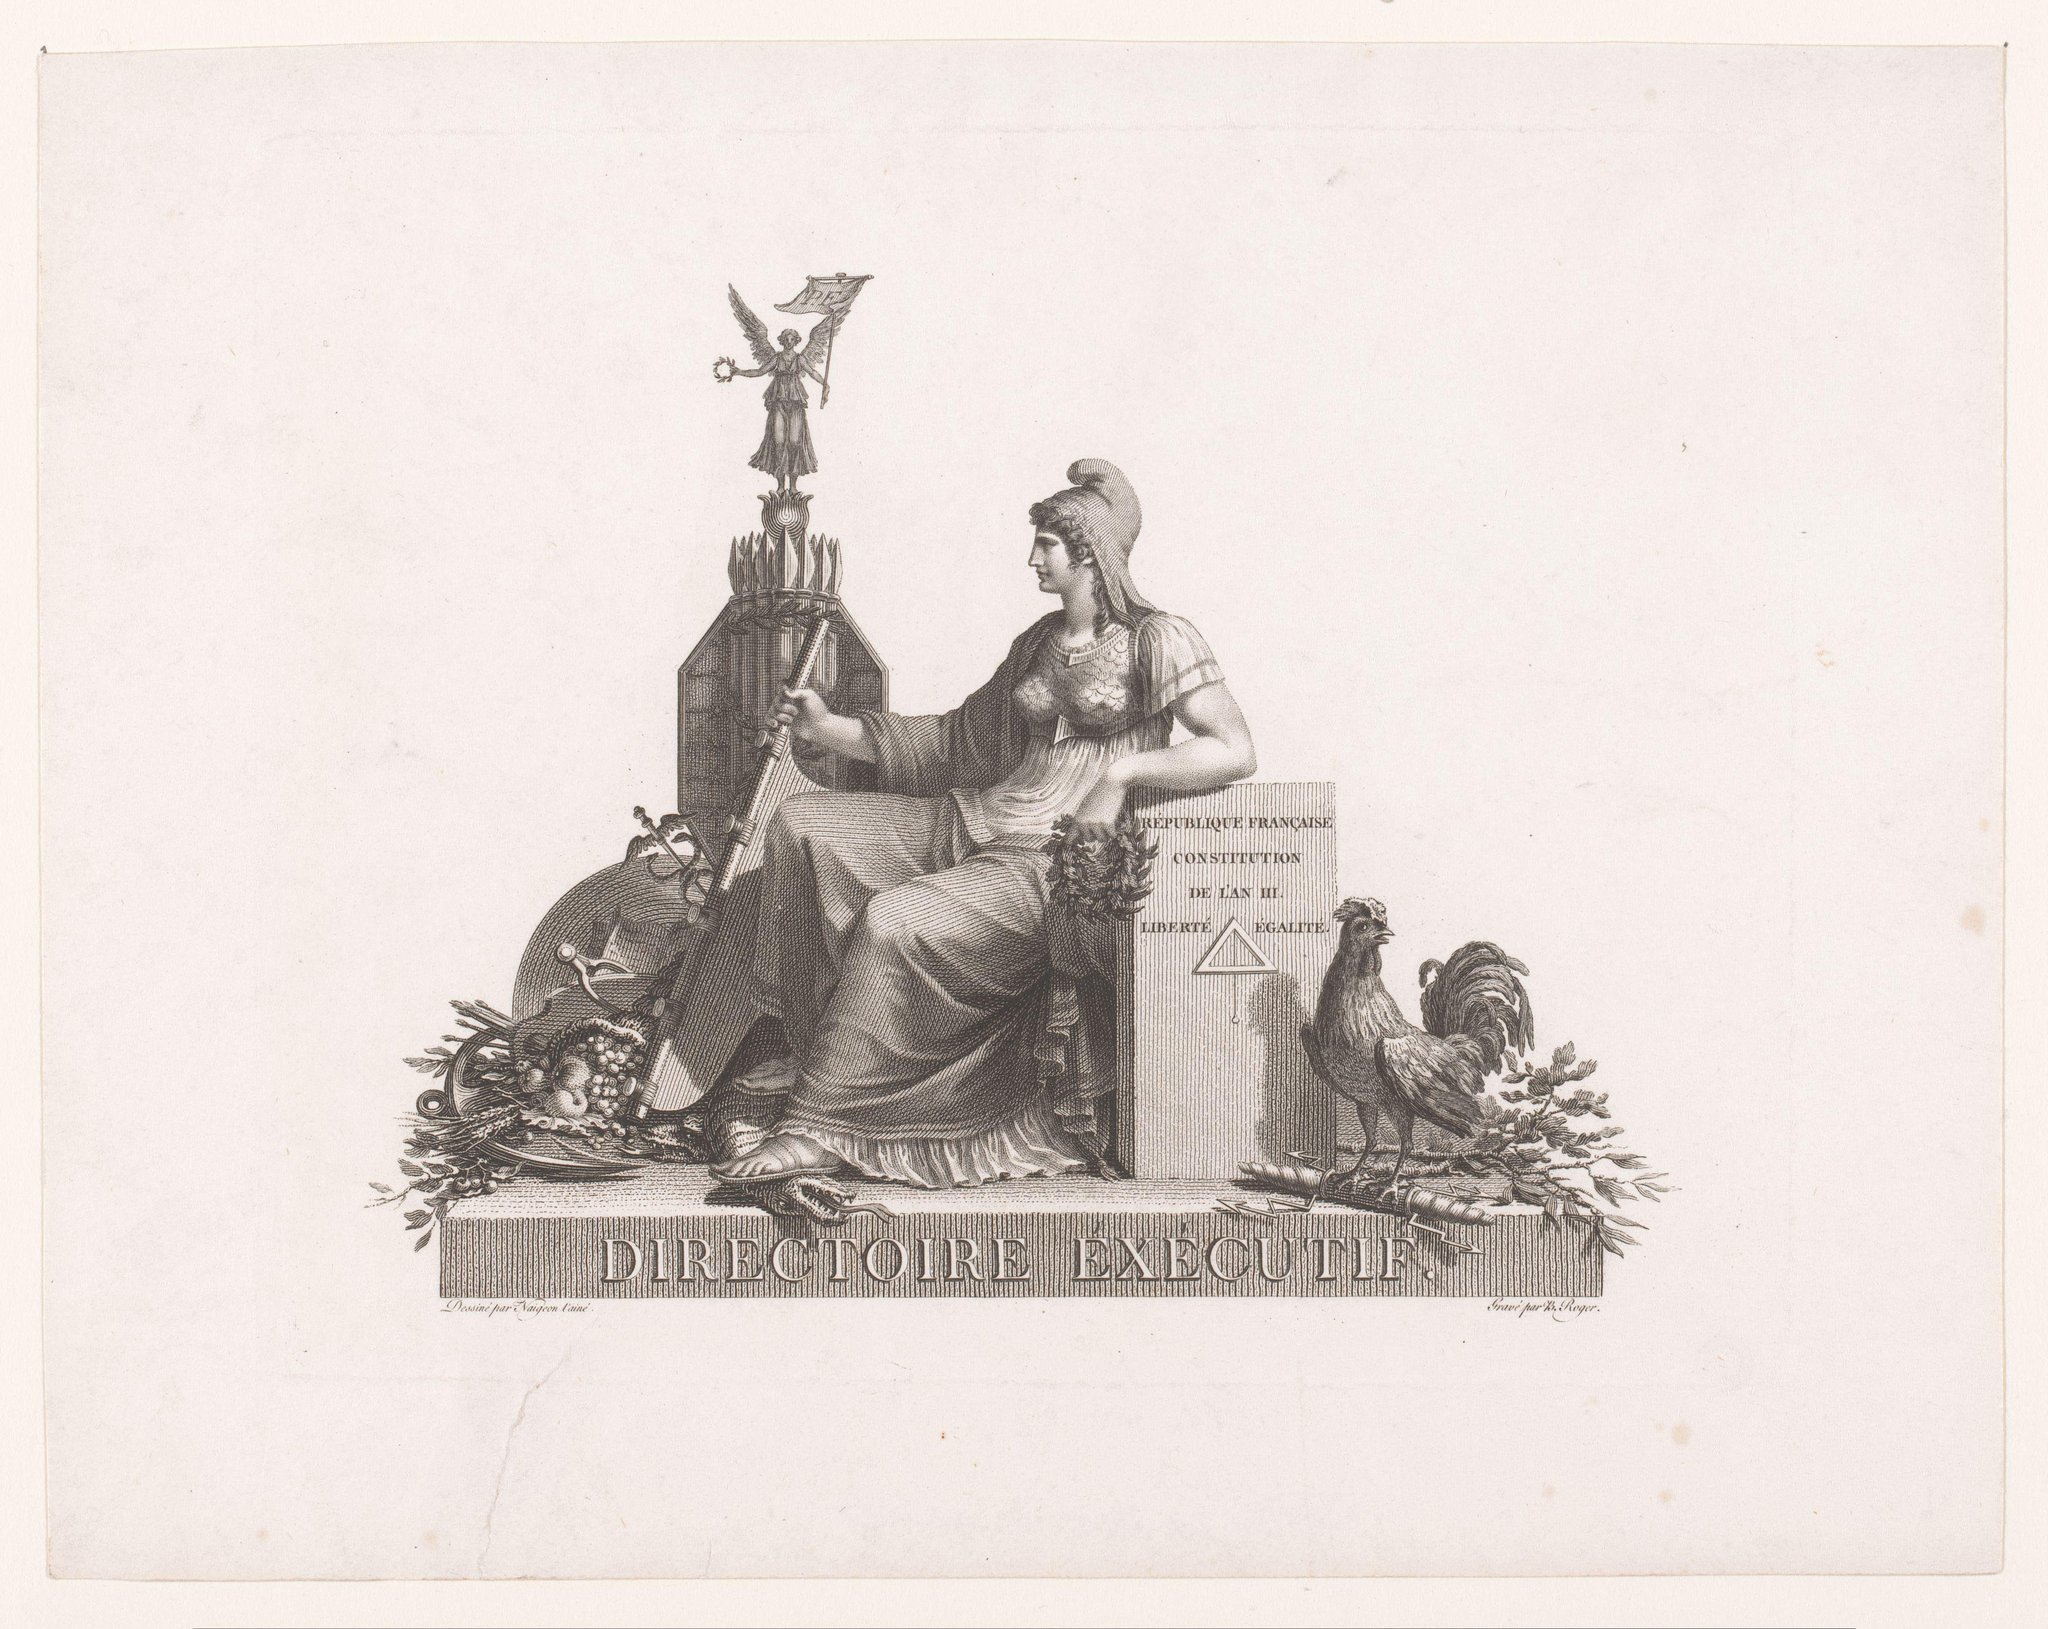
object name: print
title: République Française/ Constitution/ de l'An III./ Liberté Égalité./ Directoire Éxécutif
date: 1804-1841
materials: paper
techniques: engraving, etching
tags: governmental and representative bodies, personifications of countries, nations, states, districts, etc., warfare; military affairs, letter, envelope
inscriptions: collector's mark: Lugt 2228